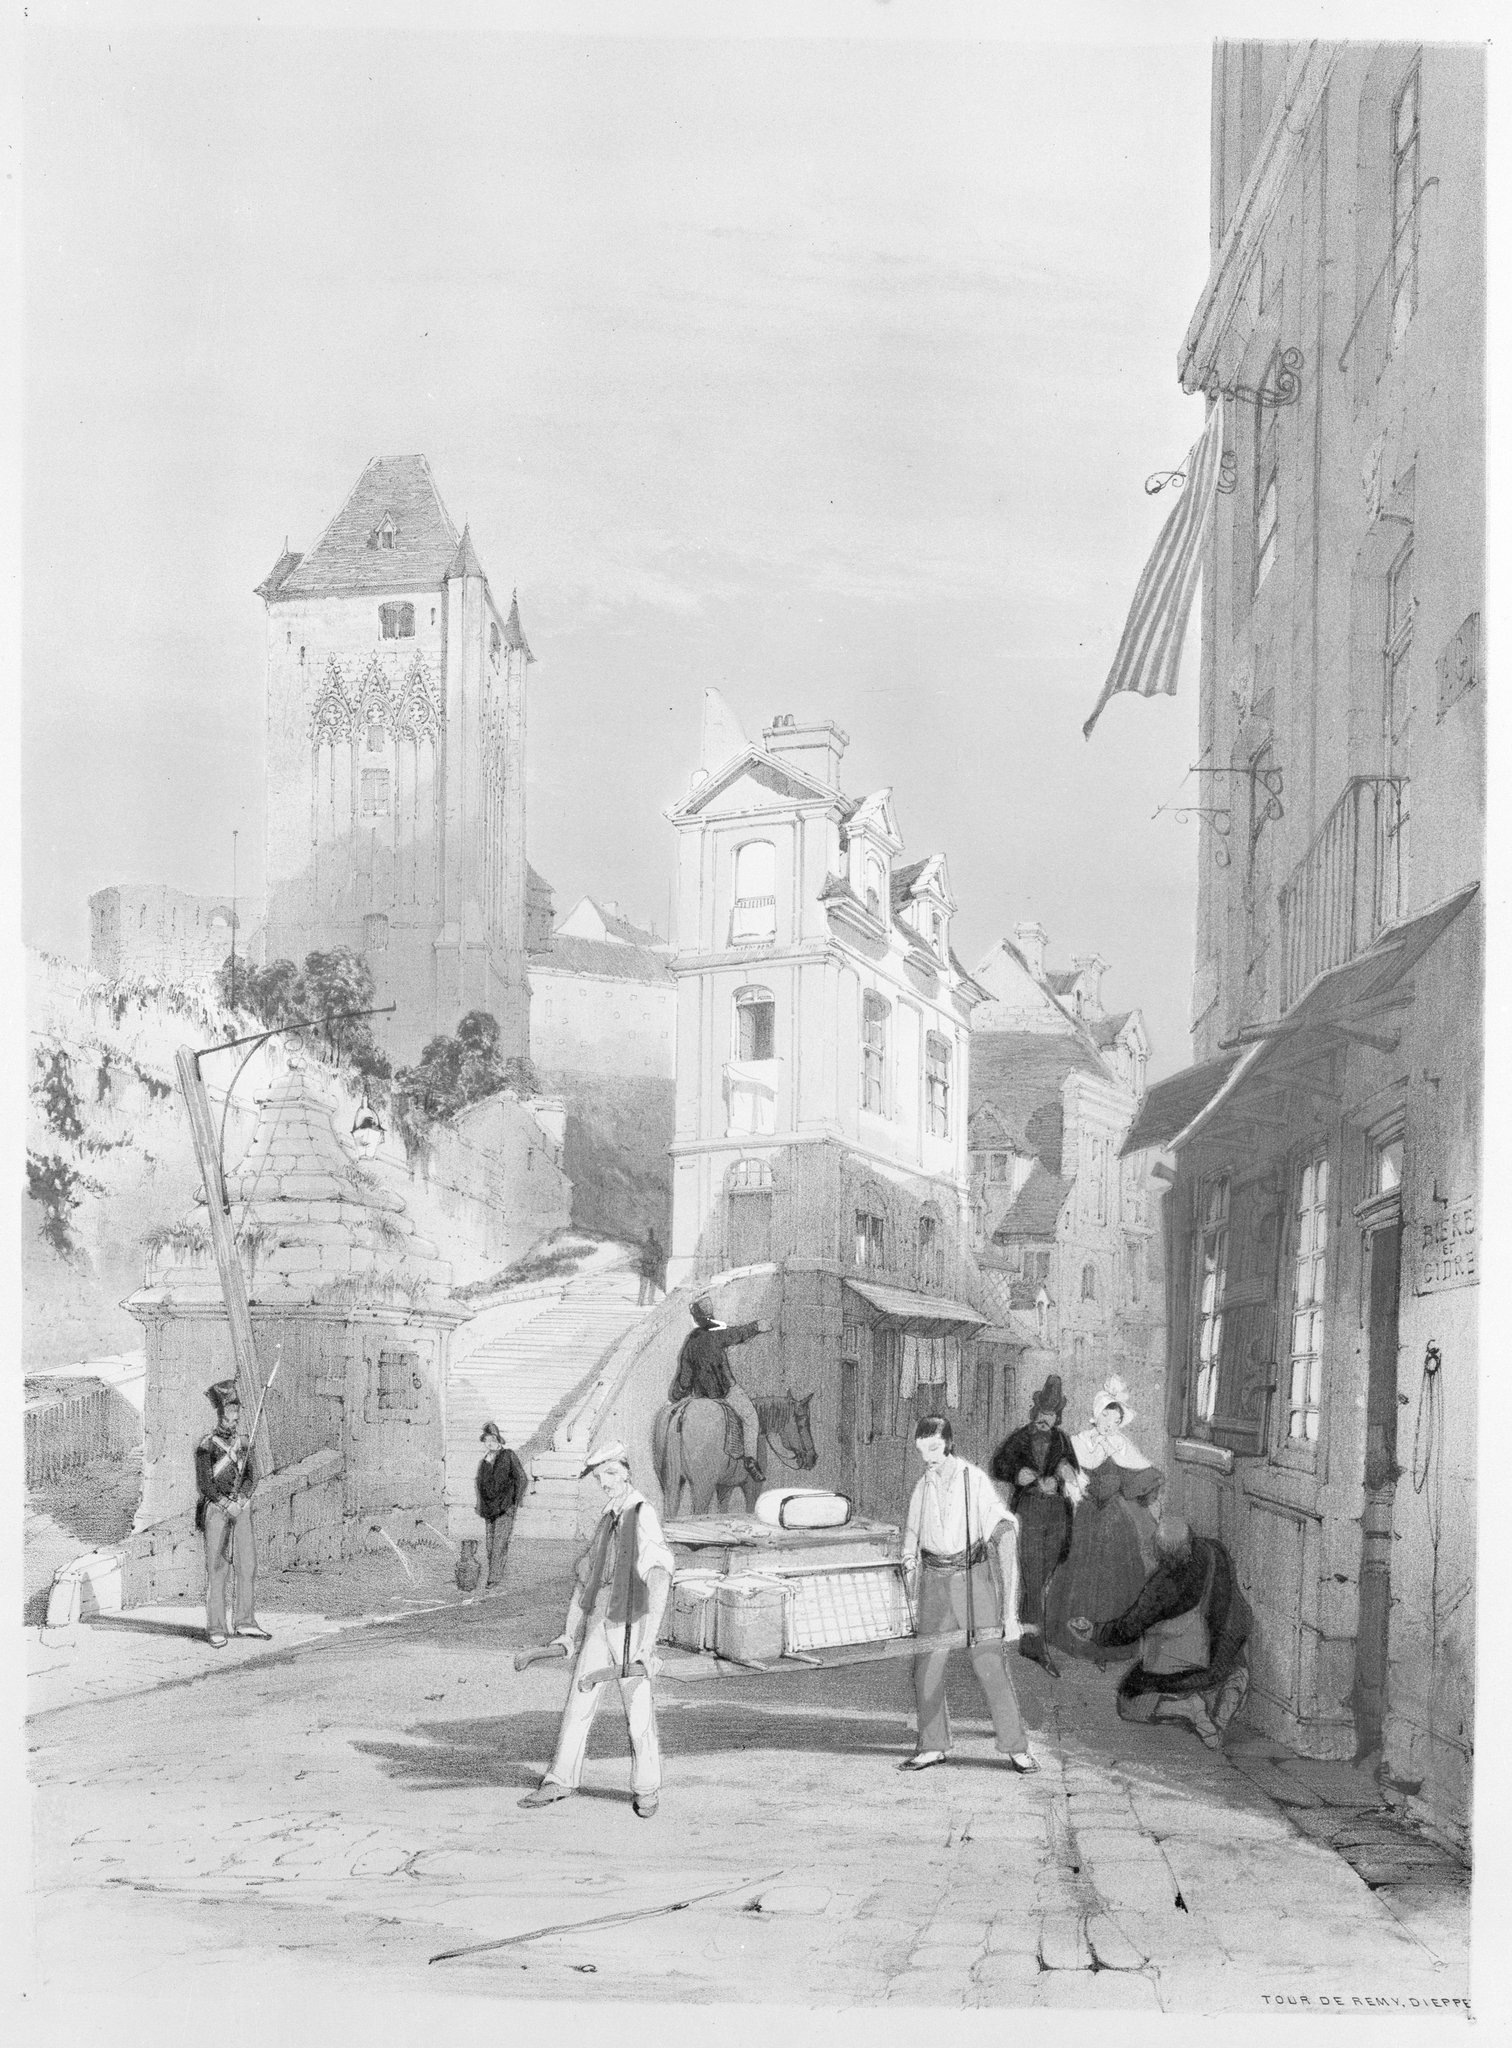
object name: print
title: Tour de Remy, Dieppe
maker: thomas shotter boys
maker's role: artist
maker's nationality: british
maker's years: 1803-1874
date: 1839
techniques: hand coloring, lithograph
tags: towns